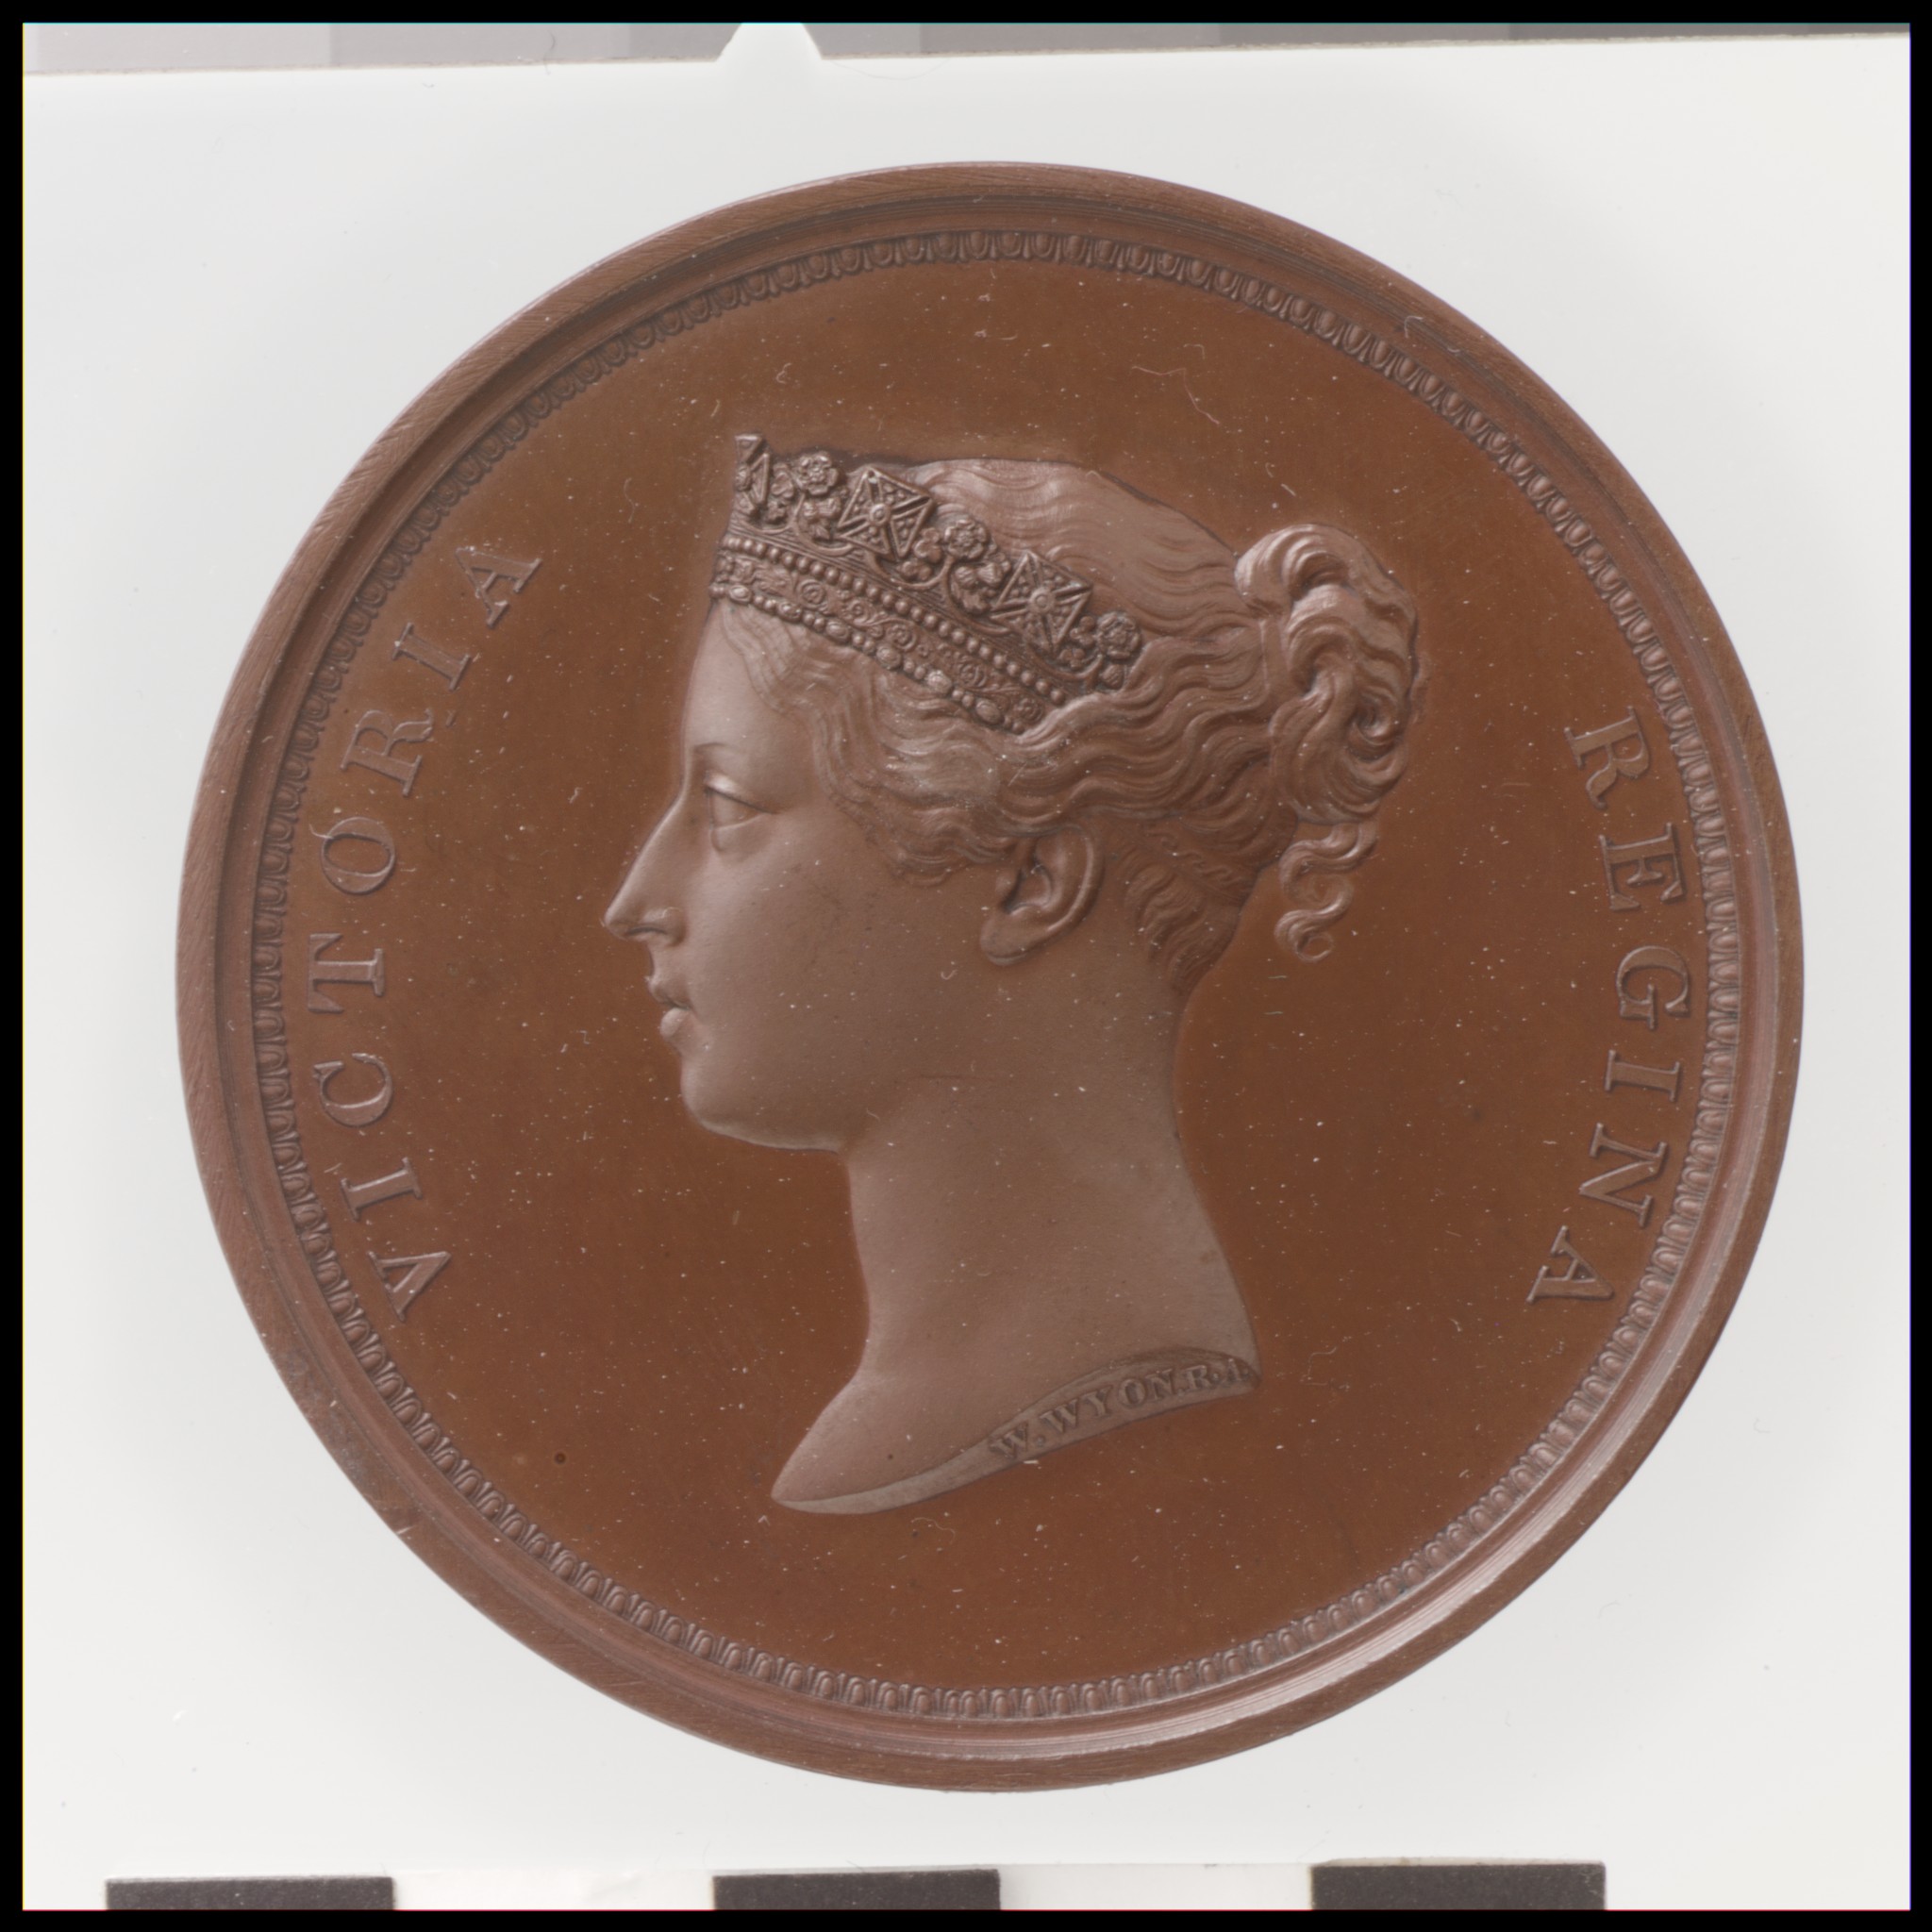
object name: medal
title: Victoria's Visit to the Corporation of London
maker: william wyon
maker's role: artist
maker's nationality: british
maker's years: 1795-1851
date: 1837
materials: bronze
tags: buildings,profiles,flags